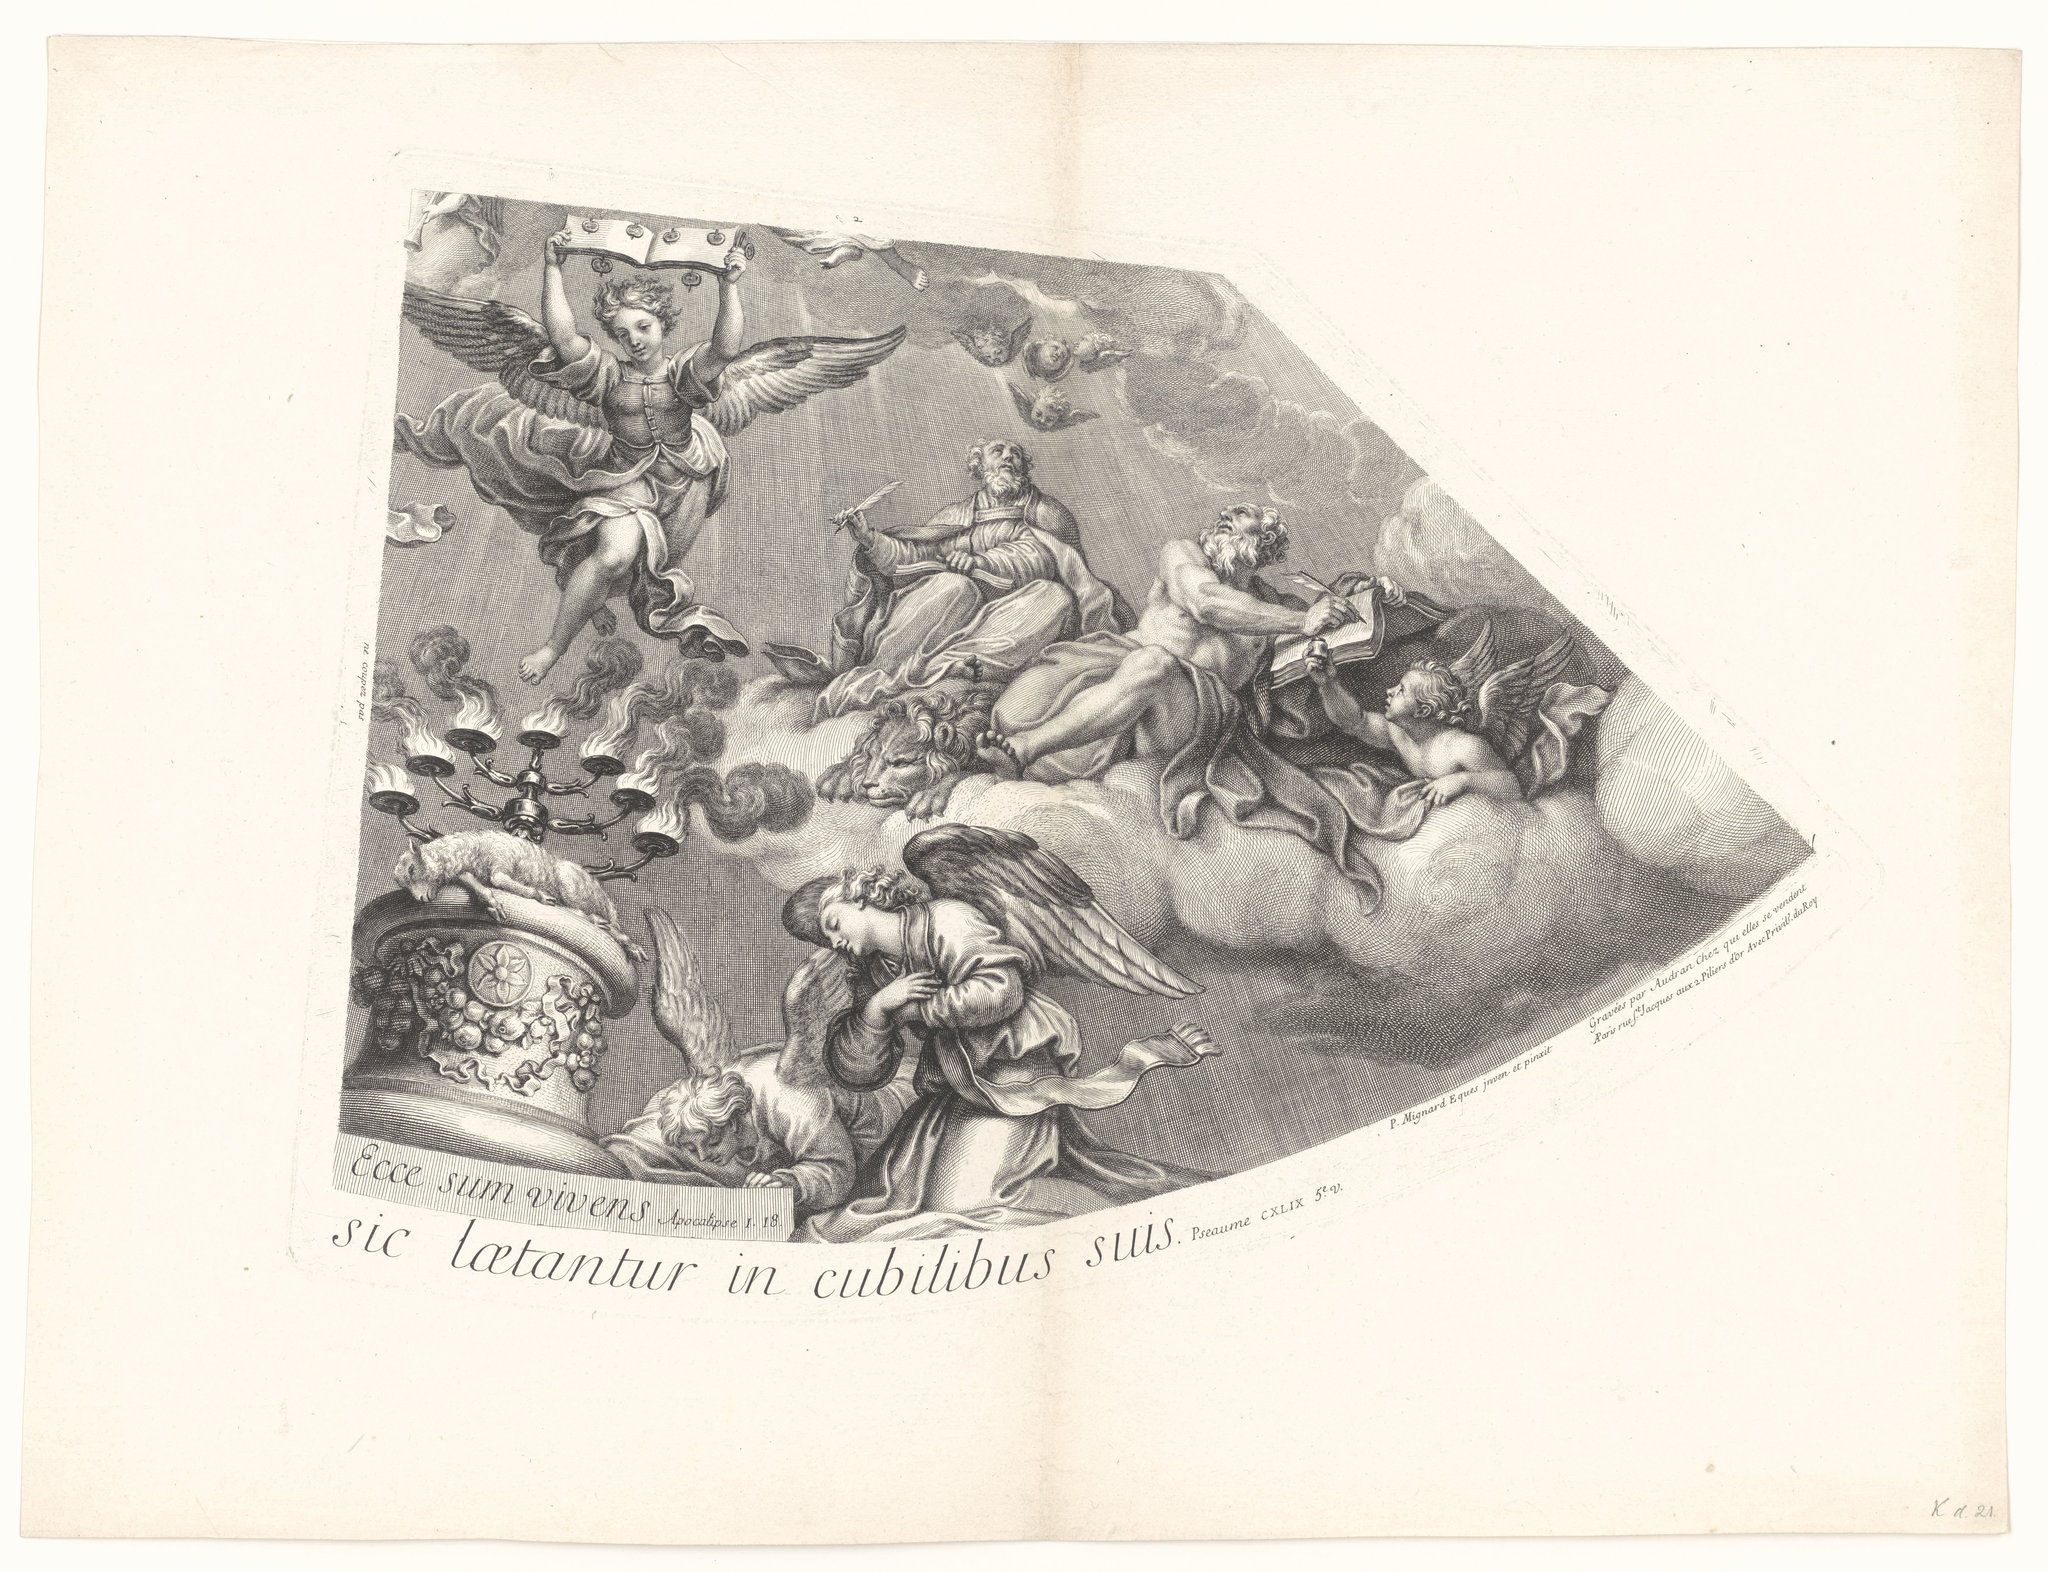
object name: print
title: Plafondschilderingen in de koepel van de kerk Val-du-Grace: o.a. engelen en profeten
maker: gérard audran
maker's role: print maker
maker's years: 1640-1703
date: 1650-1703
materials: paper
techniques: engraving, etching